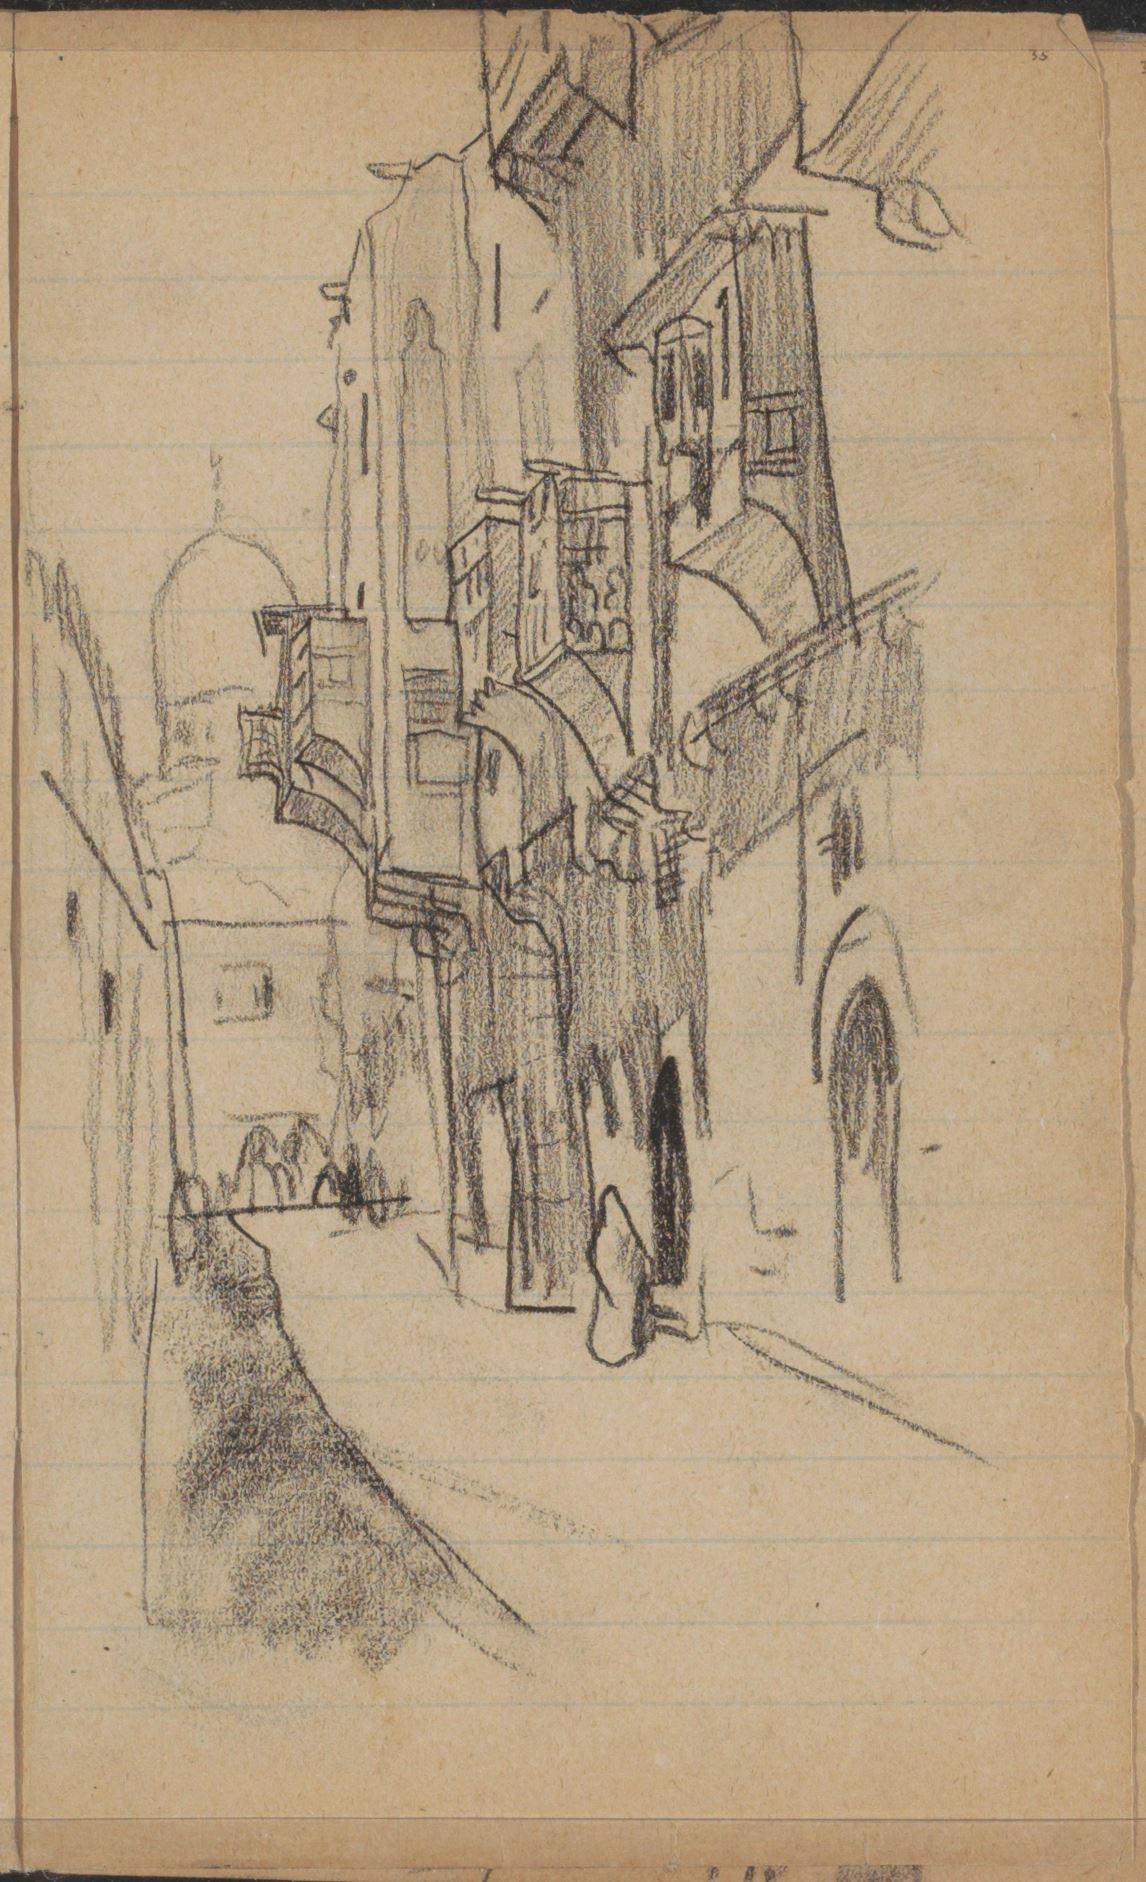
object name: sketchbook leaf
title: Straat in Caïro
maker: marius bauer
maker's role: draughtsman, print maker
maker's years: 1867-1932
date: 1894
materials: chalk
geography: cairo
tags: dome ~ architecture, street (+ city(-scape) with figures, staffage)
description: Aan het eind van de straat is het koepeldak van de Al-Azhar moskee te zien. Pagina 35 uit een schetsboek met 48 bladen.